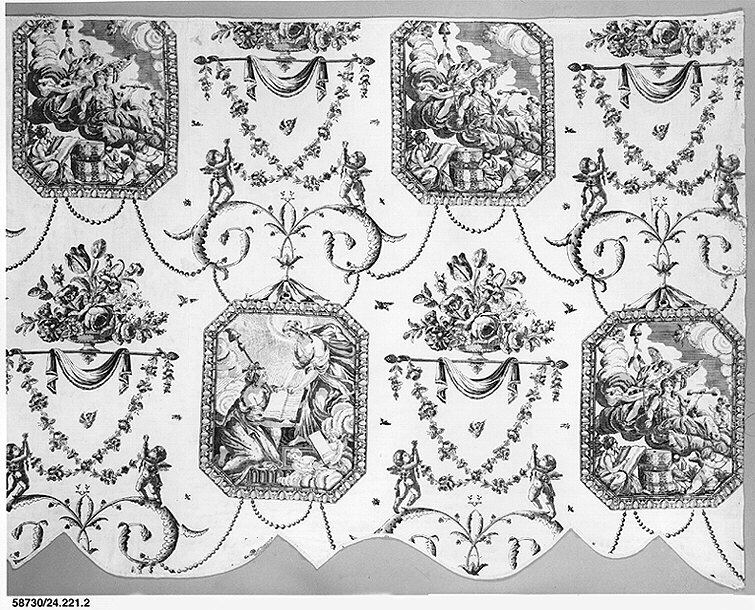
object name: valance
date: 1767-1800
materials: linen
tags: men,women,flowers